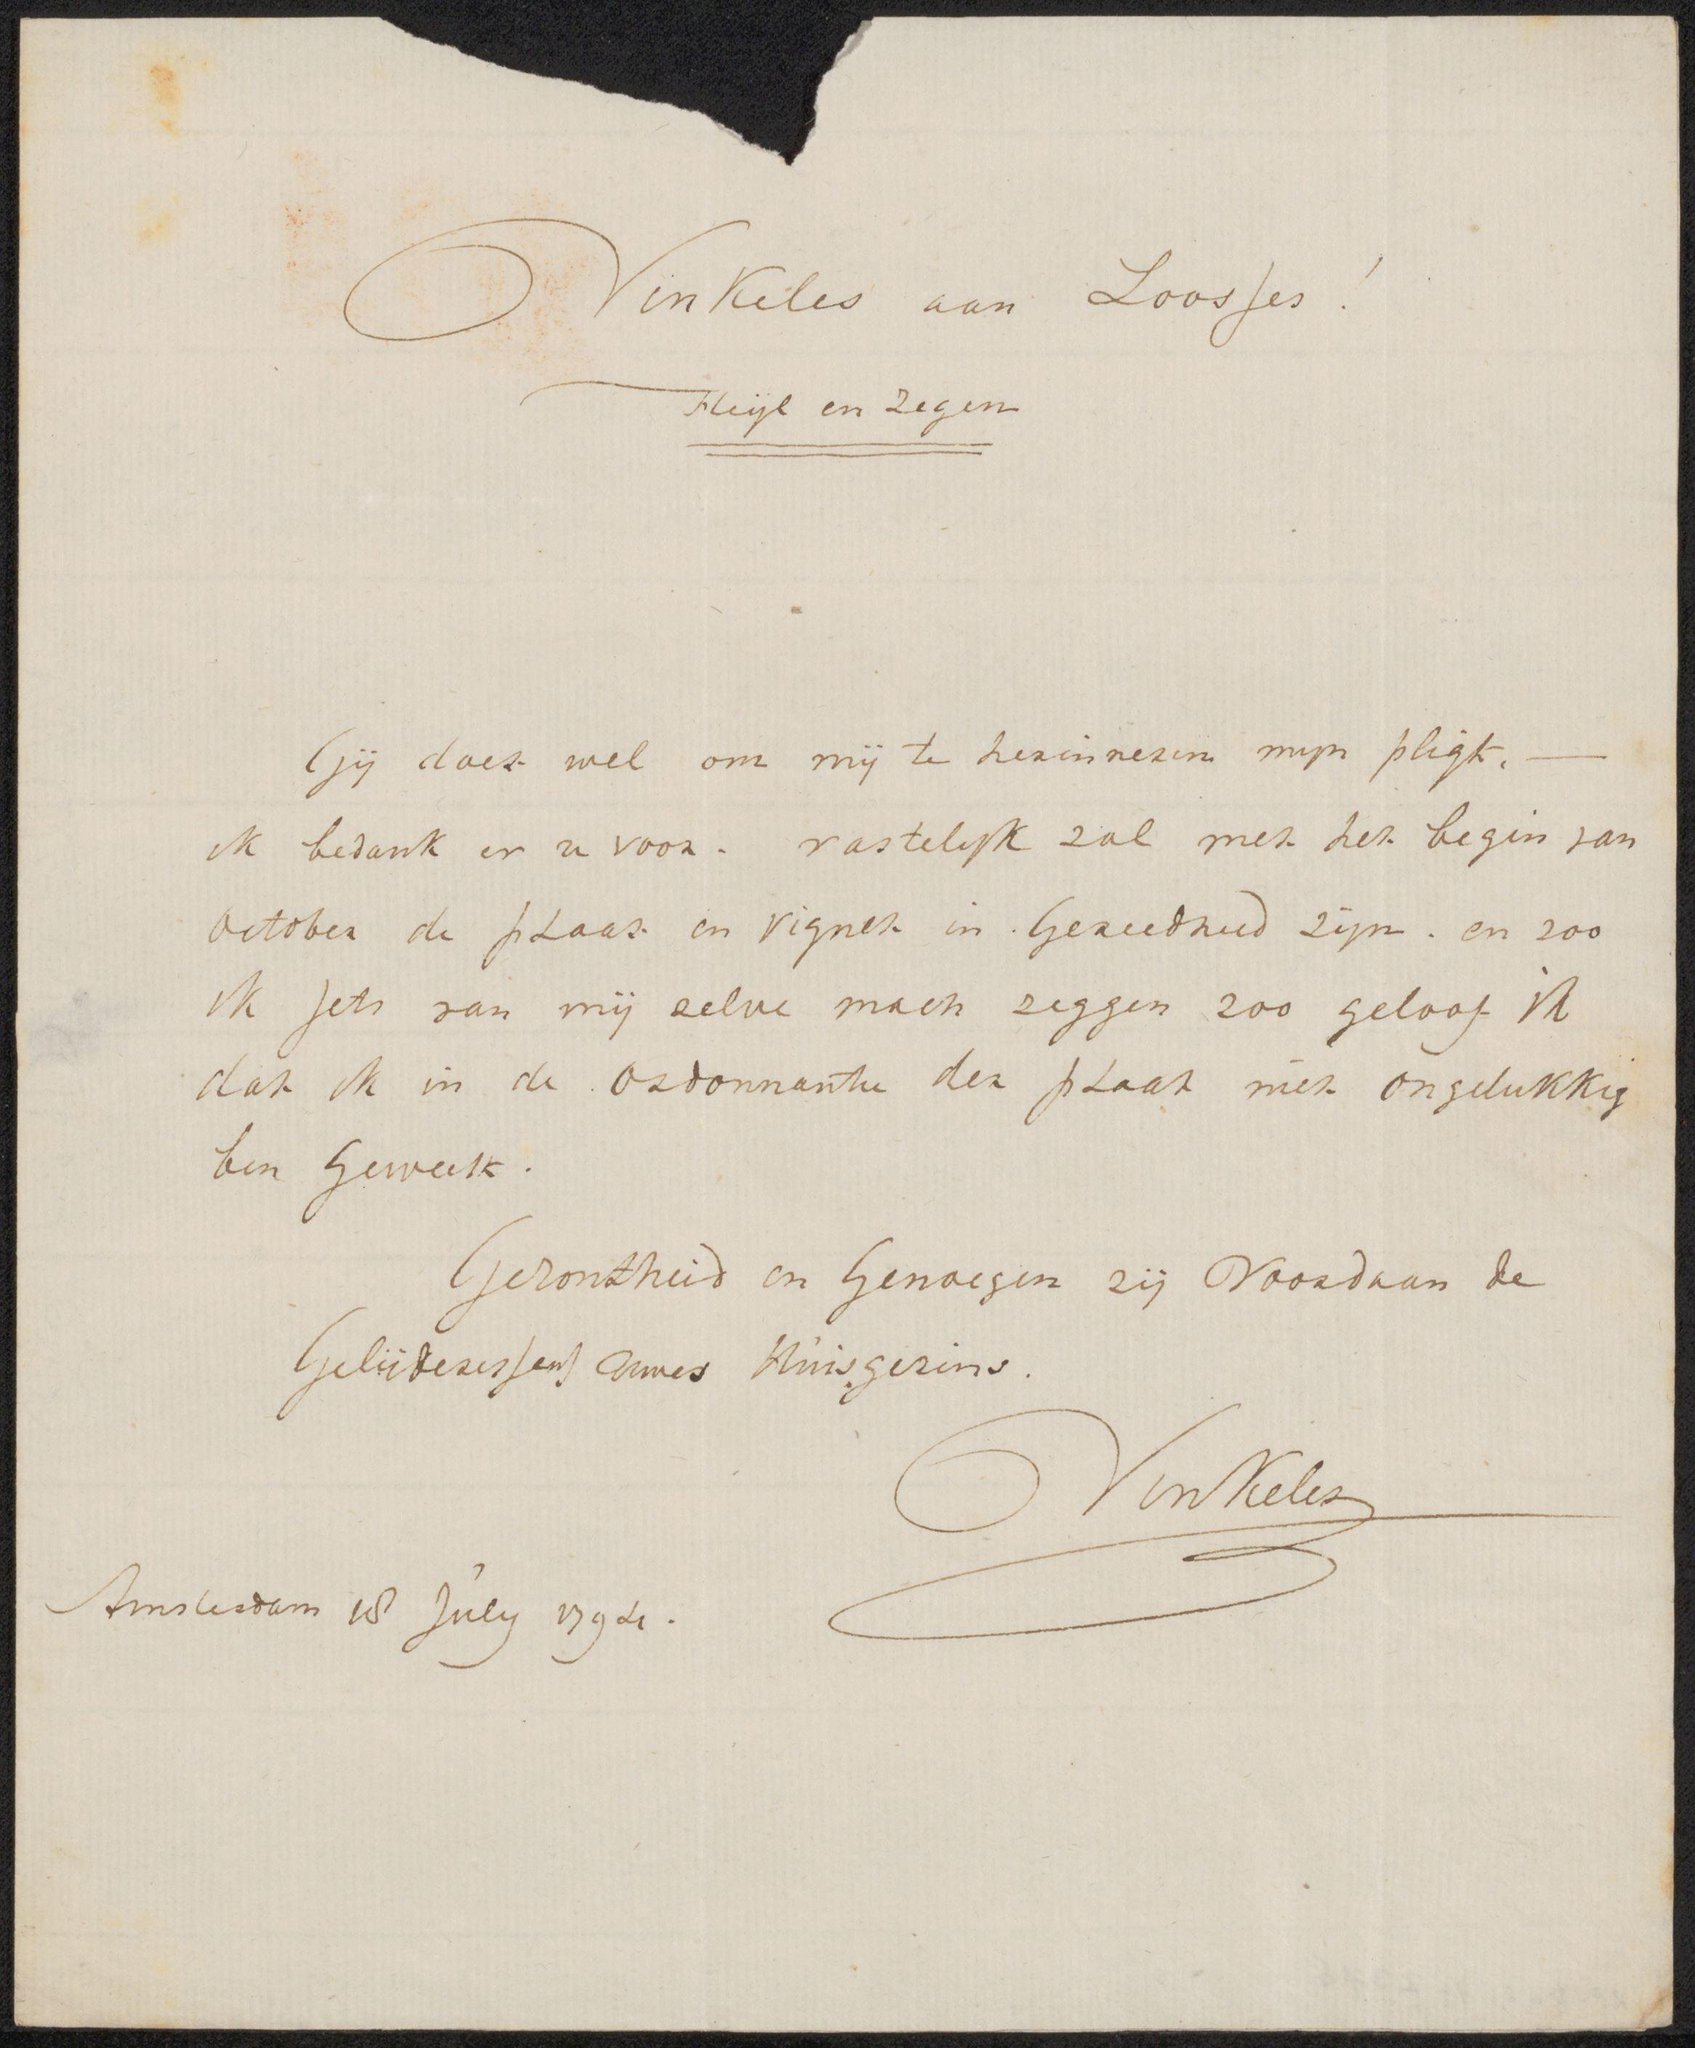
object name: letter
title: Brief aan Adriaan Pietersz. Loosjes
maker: reinier vinkeles (i)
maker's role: draughtsman, print maker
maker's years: 1741-1816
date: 1794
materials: ink, paper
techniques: pen, writing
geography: amsterdam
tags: haarlem, publisher, bookseller, adriaan pietersz. loosjes, the graphic arts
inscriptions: watermark